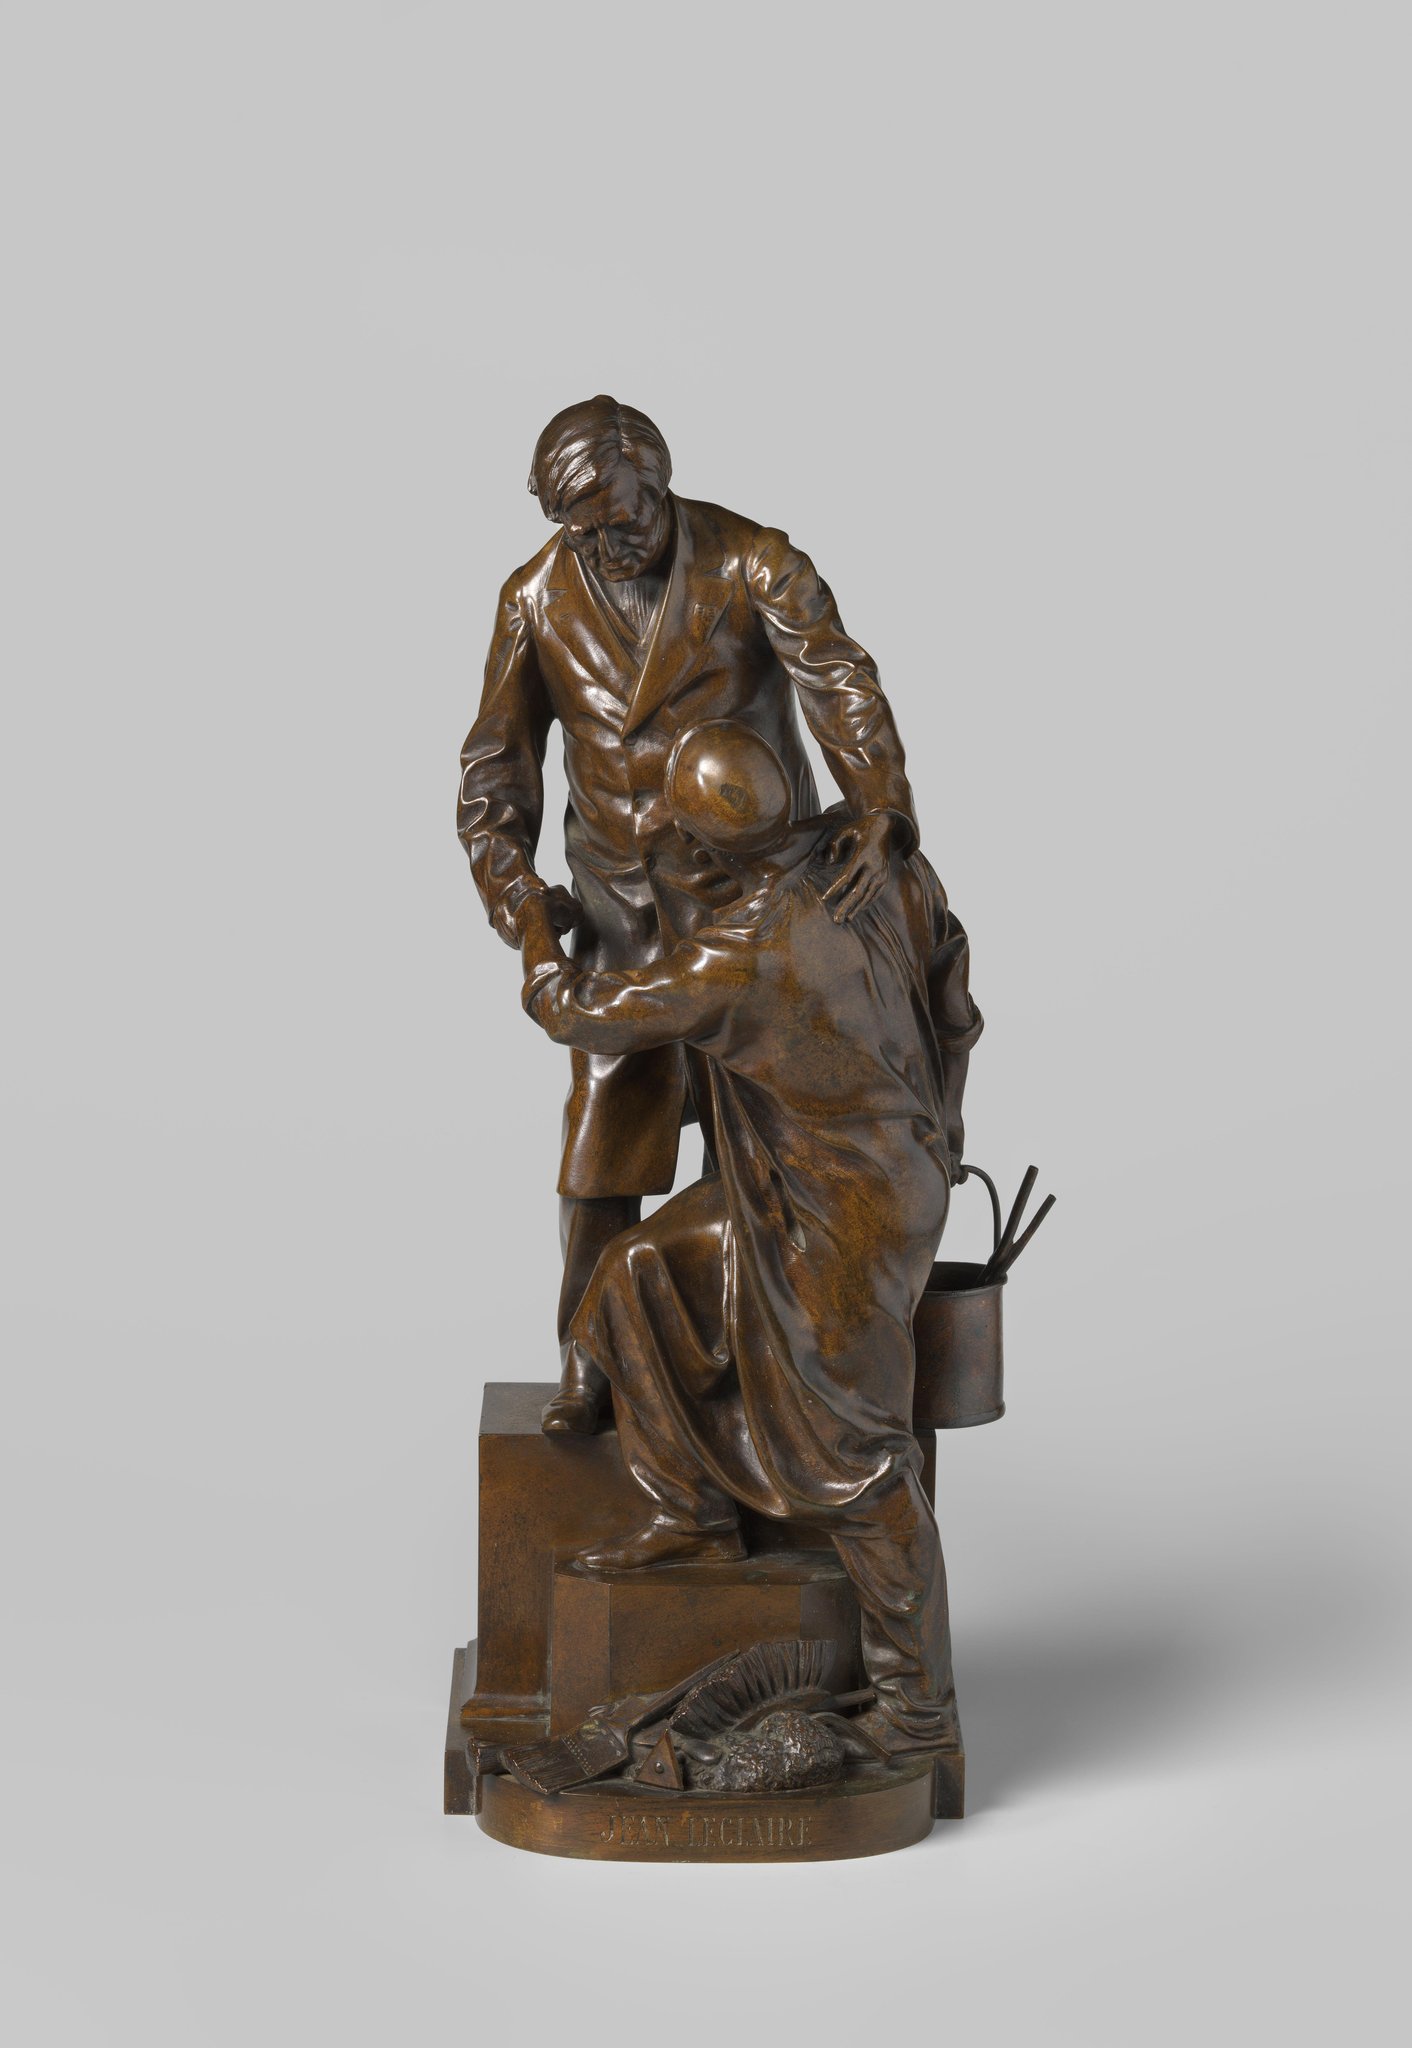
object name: sculpture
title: Monument voor Edmé Jean Leclaire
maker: aimé-jules dalou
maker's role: sculptor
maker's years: 1838-1902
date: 1899-1900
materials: bronze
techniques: casting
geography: paris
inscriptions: mark: ‘DALOU’, mark: ‘FUMIERE THIEBAUT FR[e]R[e]S PARIS ET C[ompagn]IE SUC[cesseu]RS (in cirkel)’